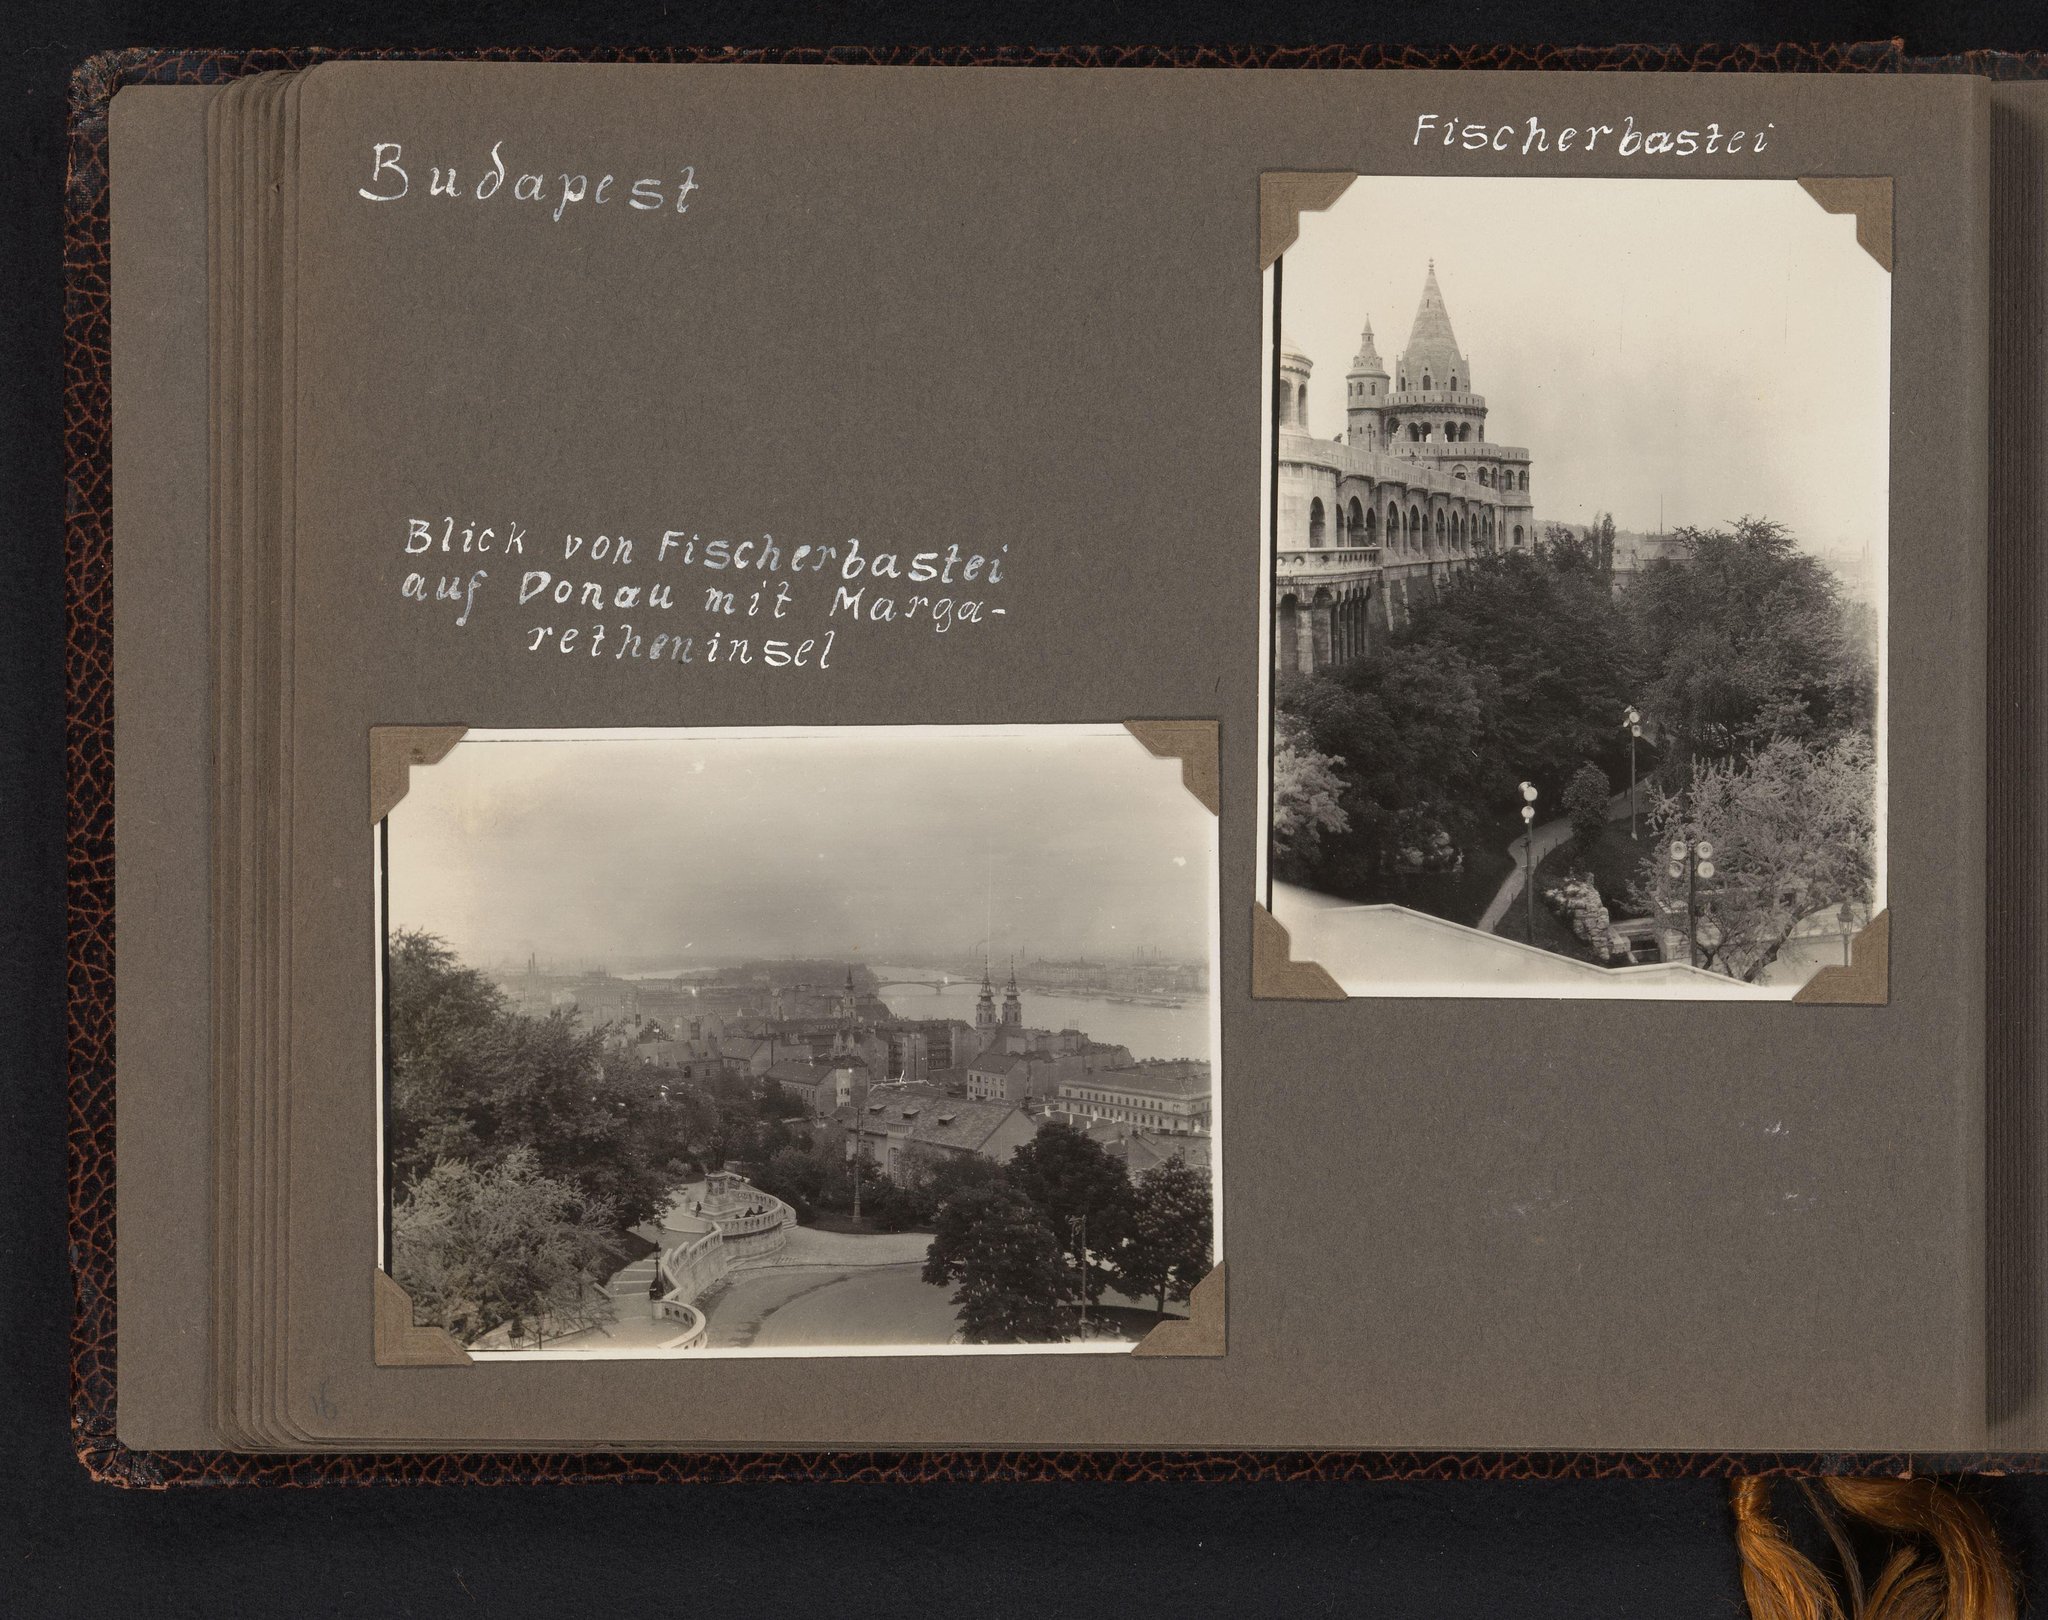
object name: photograph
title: Twee gezichten op Boedapest en het Vissersbastion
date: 1930-1931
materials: cardboard, paper, photographic support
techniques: gelatin silver print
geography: budapest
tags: city-view in general; 'veduta', river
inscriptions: annotation: ‘Budapest/ Blick von Fischerbastei auf Donau mit Margaretheninsel/ Fischerbastei’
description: Twee foto's gemaakt tijdens het verblijf in Boedapest. Deze pagina maakt deel uit van een album.